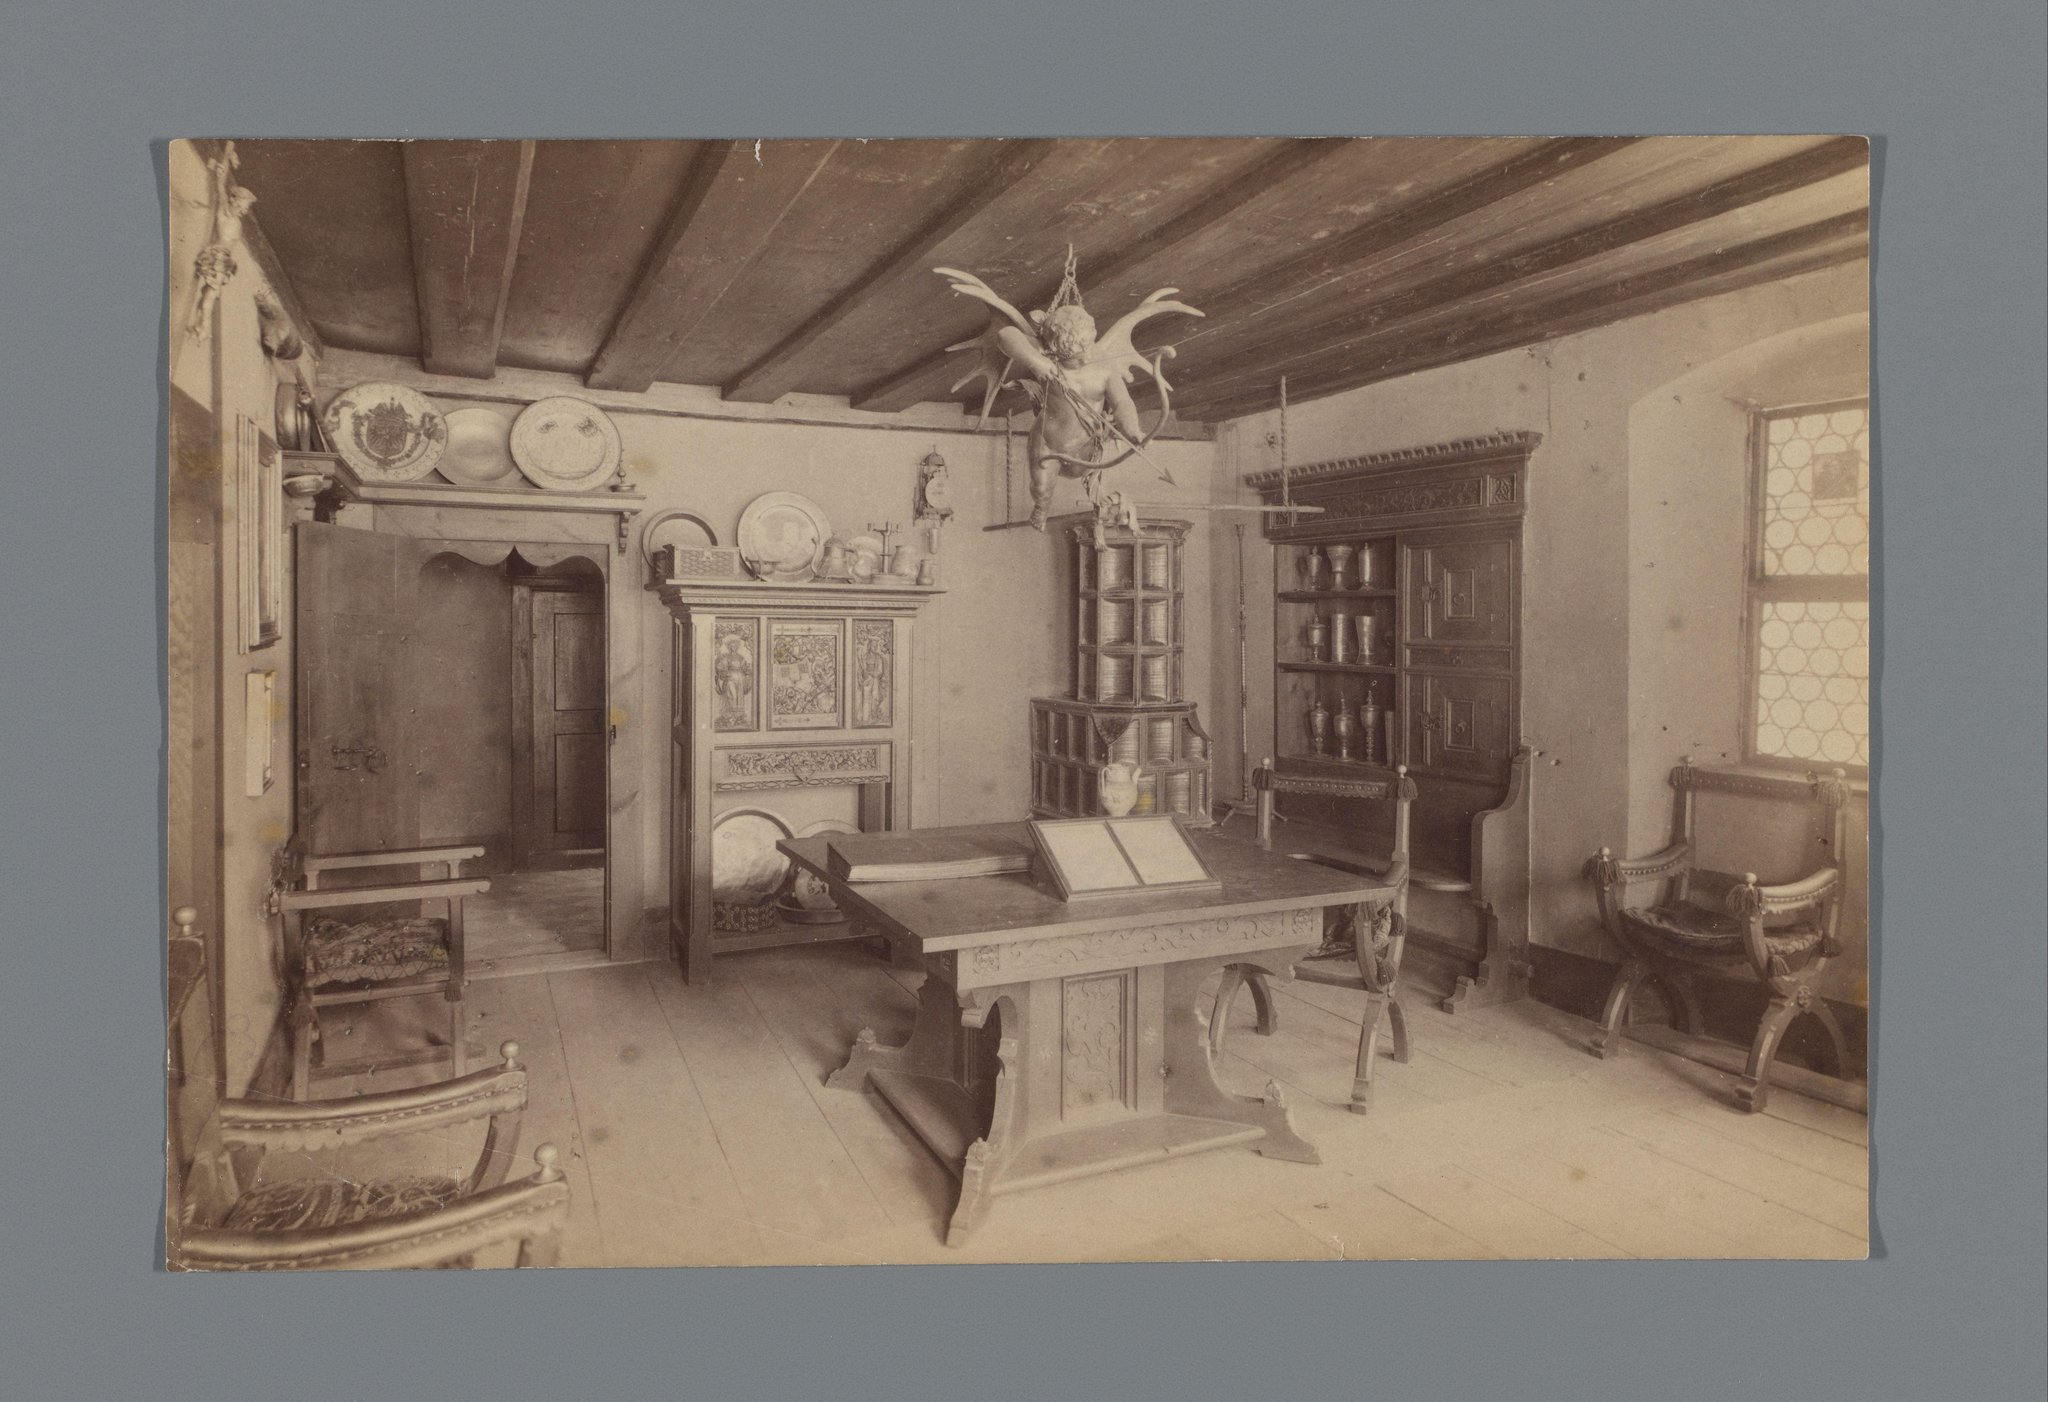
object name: photograph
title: Dürer's Zimmer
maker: Anonymous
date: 1850-1900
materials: photographic support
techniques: albumen print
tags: albrecht-dürer huis